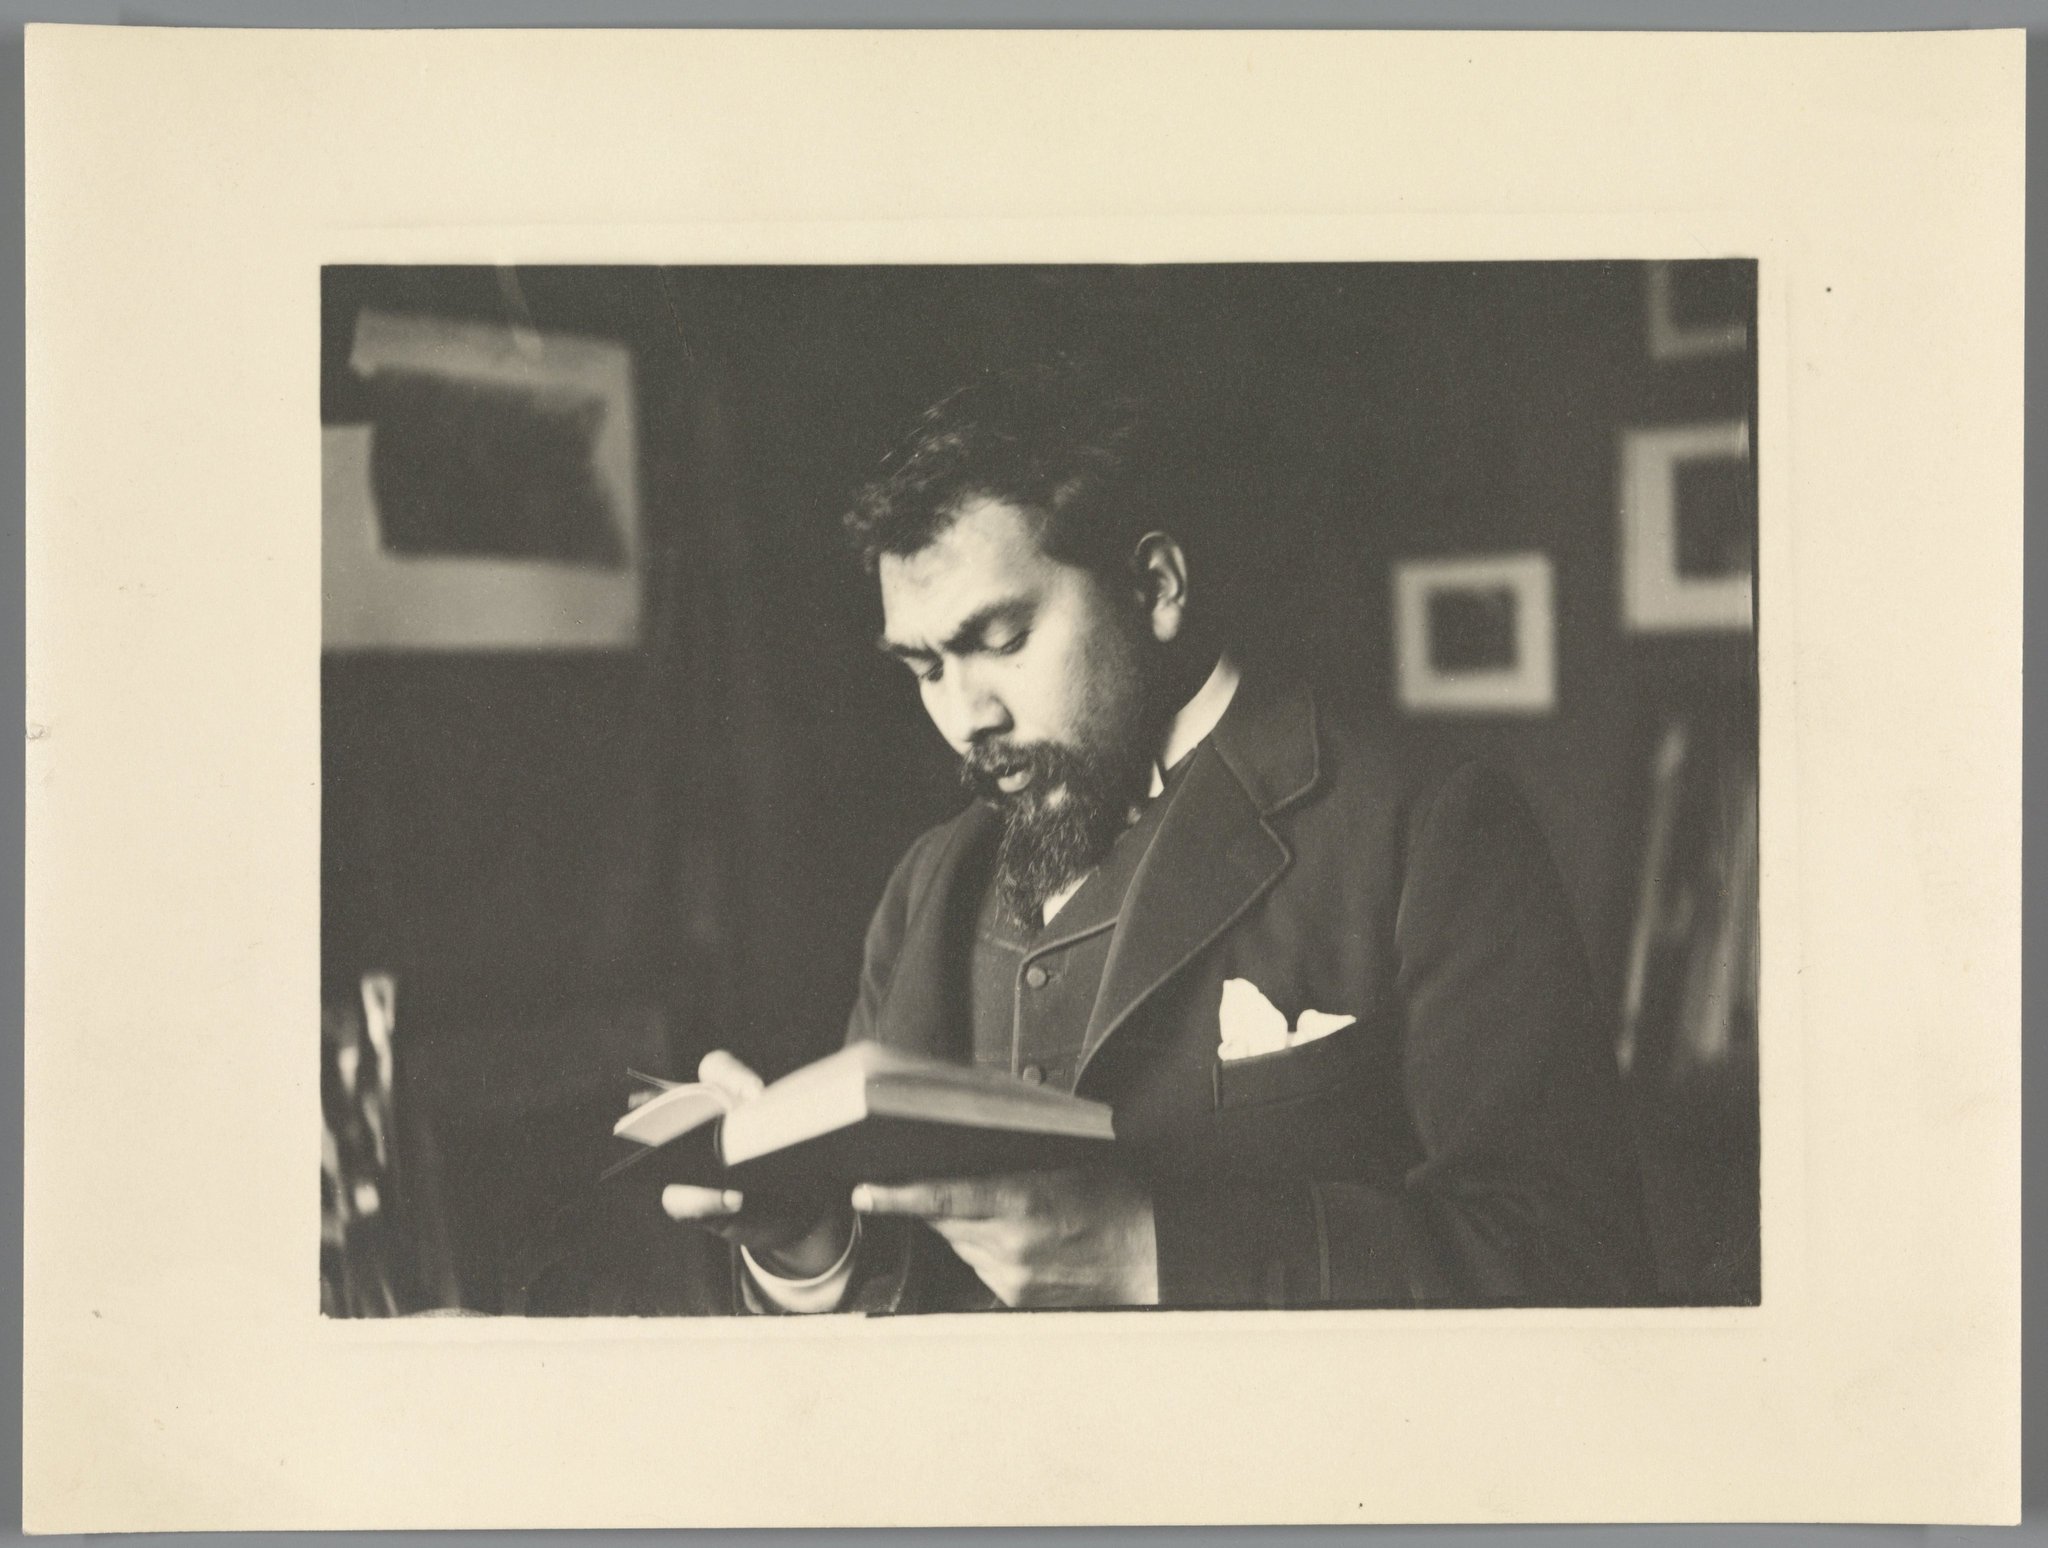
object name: photograph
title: Reproductie naar een foto van Willem Witsen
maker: Anonymous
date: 1860-1915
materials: paper, photographic support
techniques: gelatin silver print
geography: netherlands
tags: the hague, painter, print maker, draughtsman, jan toorop